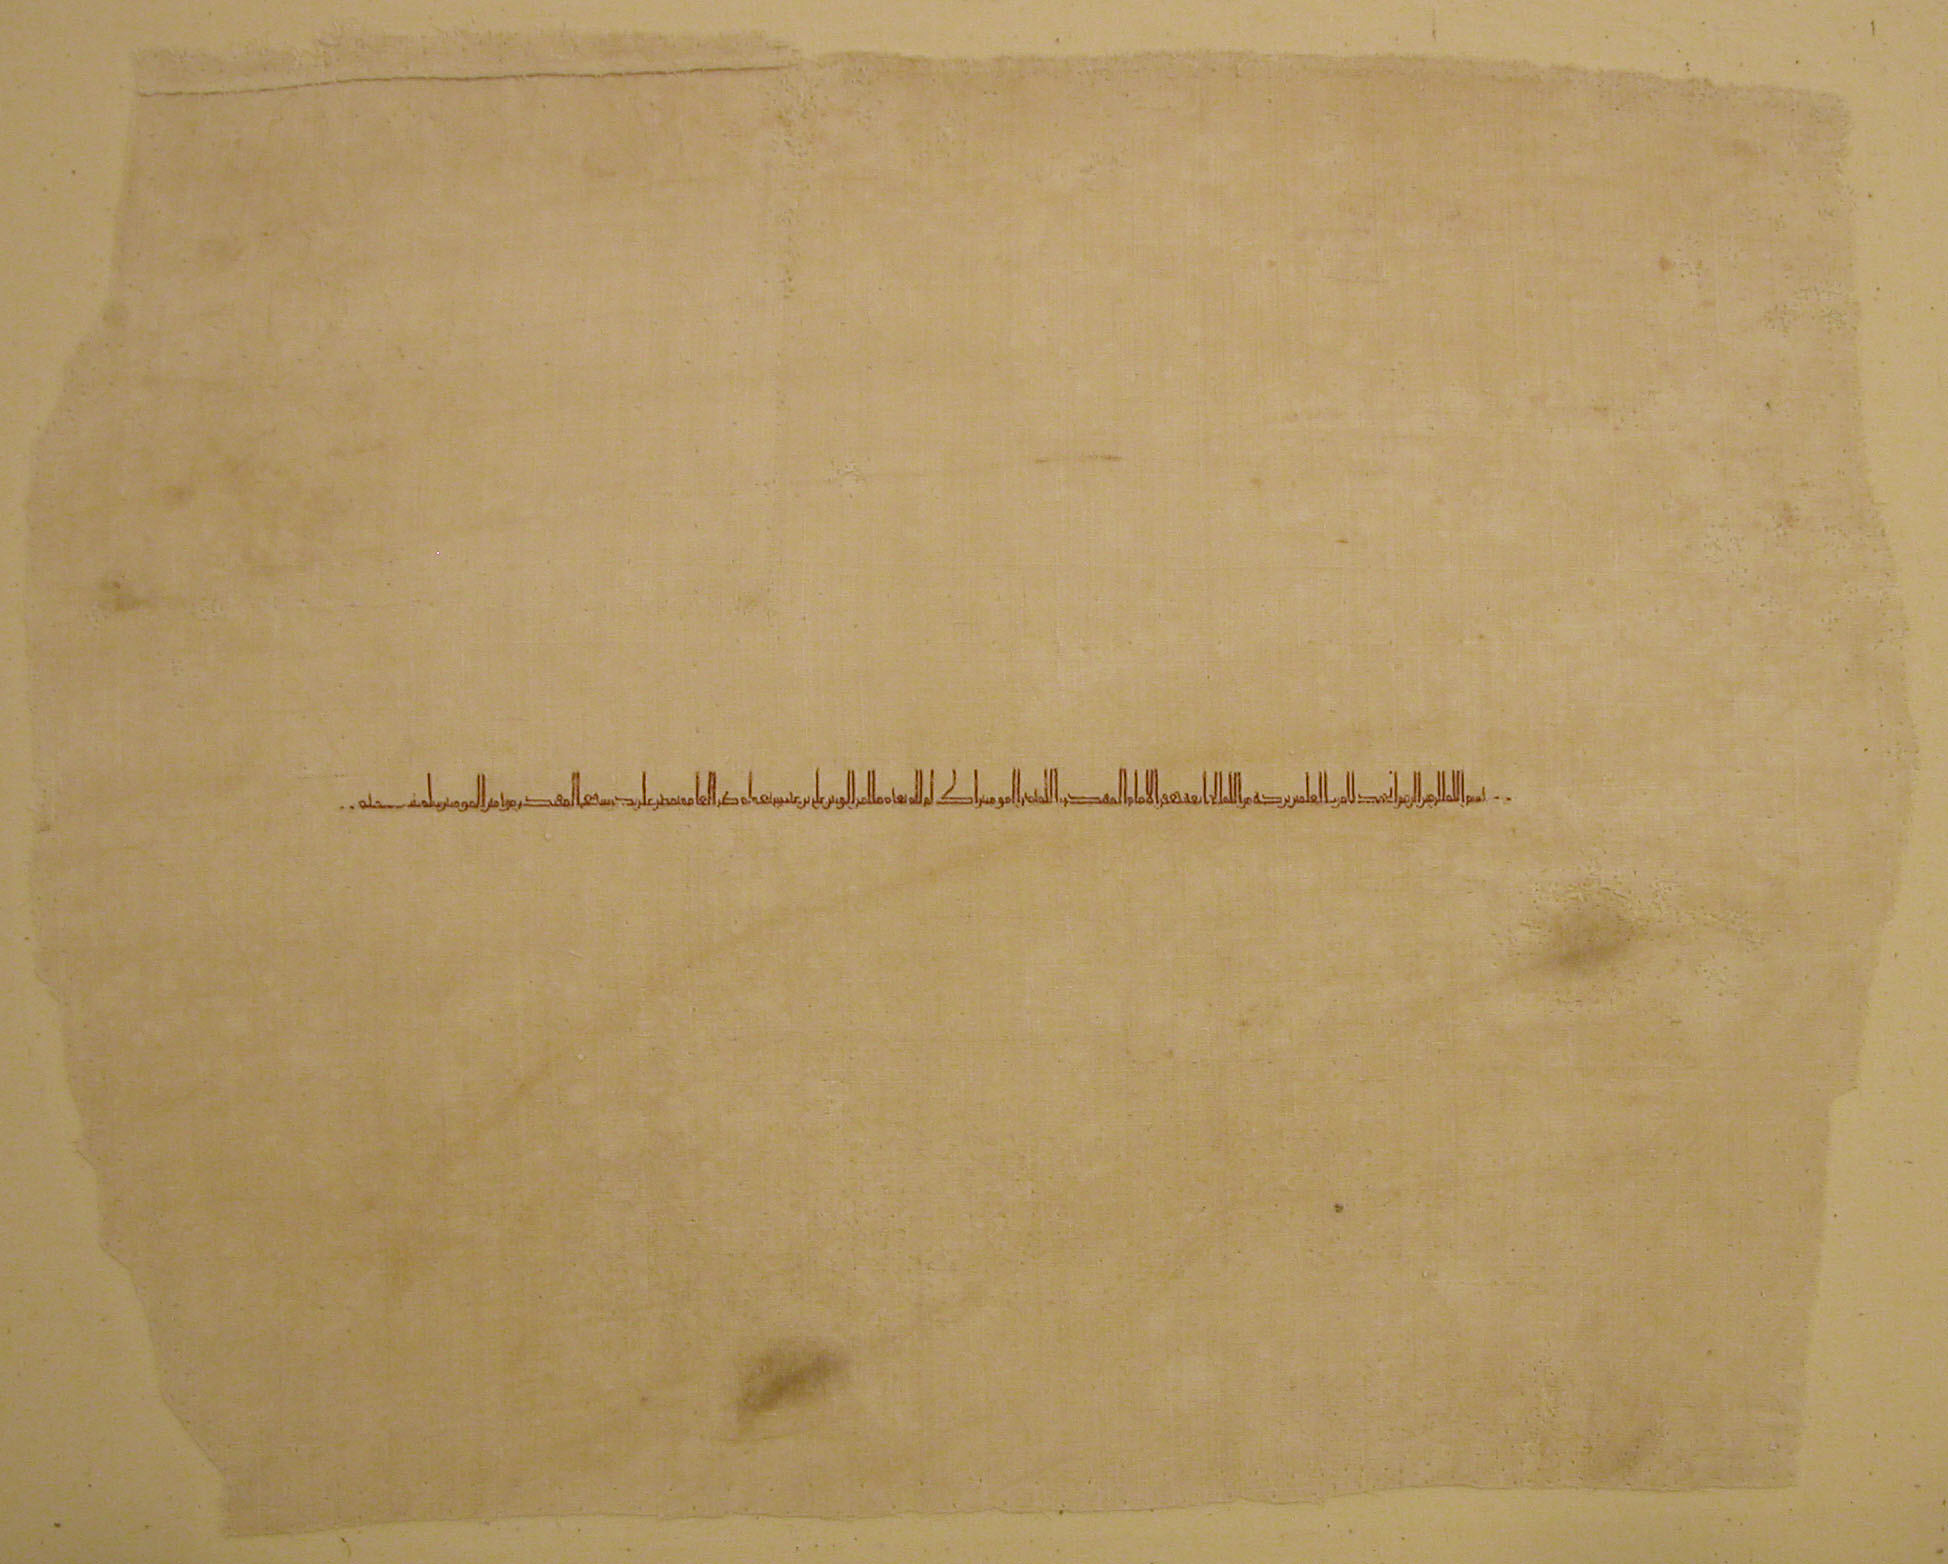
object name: textile fragment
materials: linen, silk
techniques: embroidery, weave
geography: egypt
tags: arabic